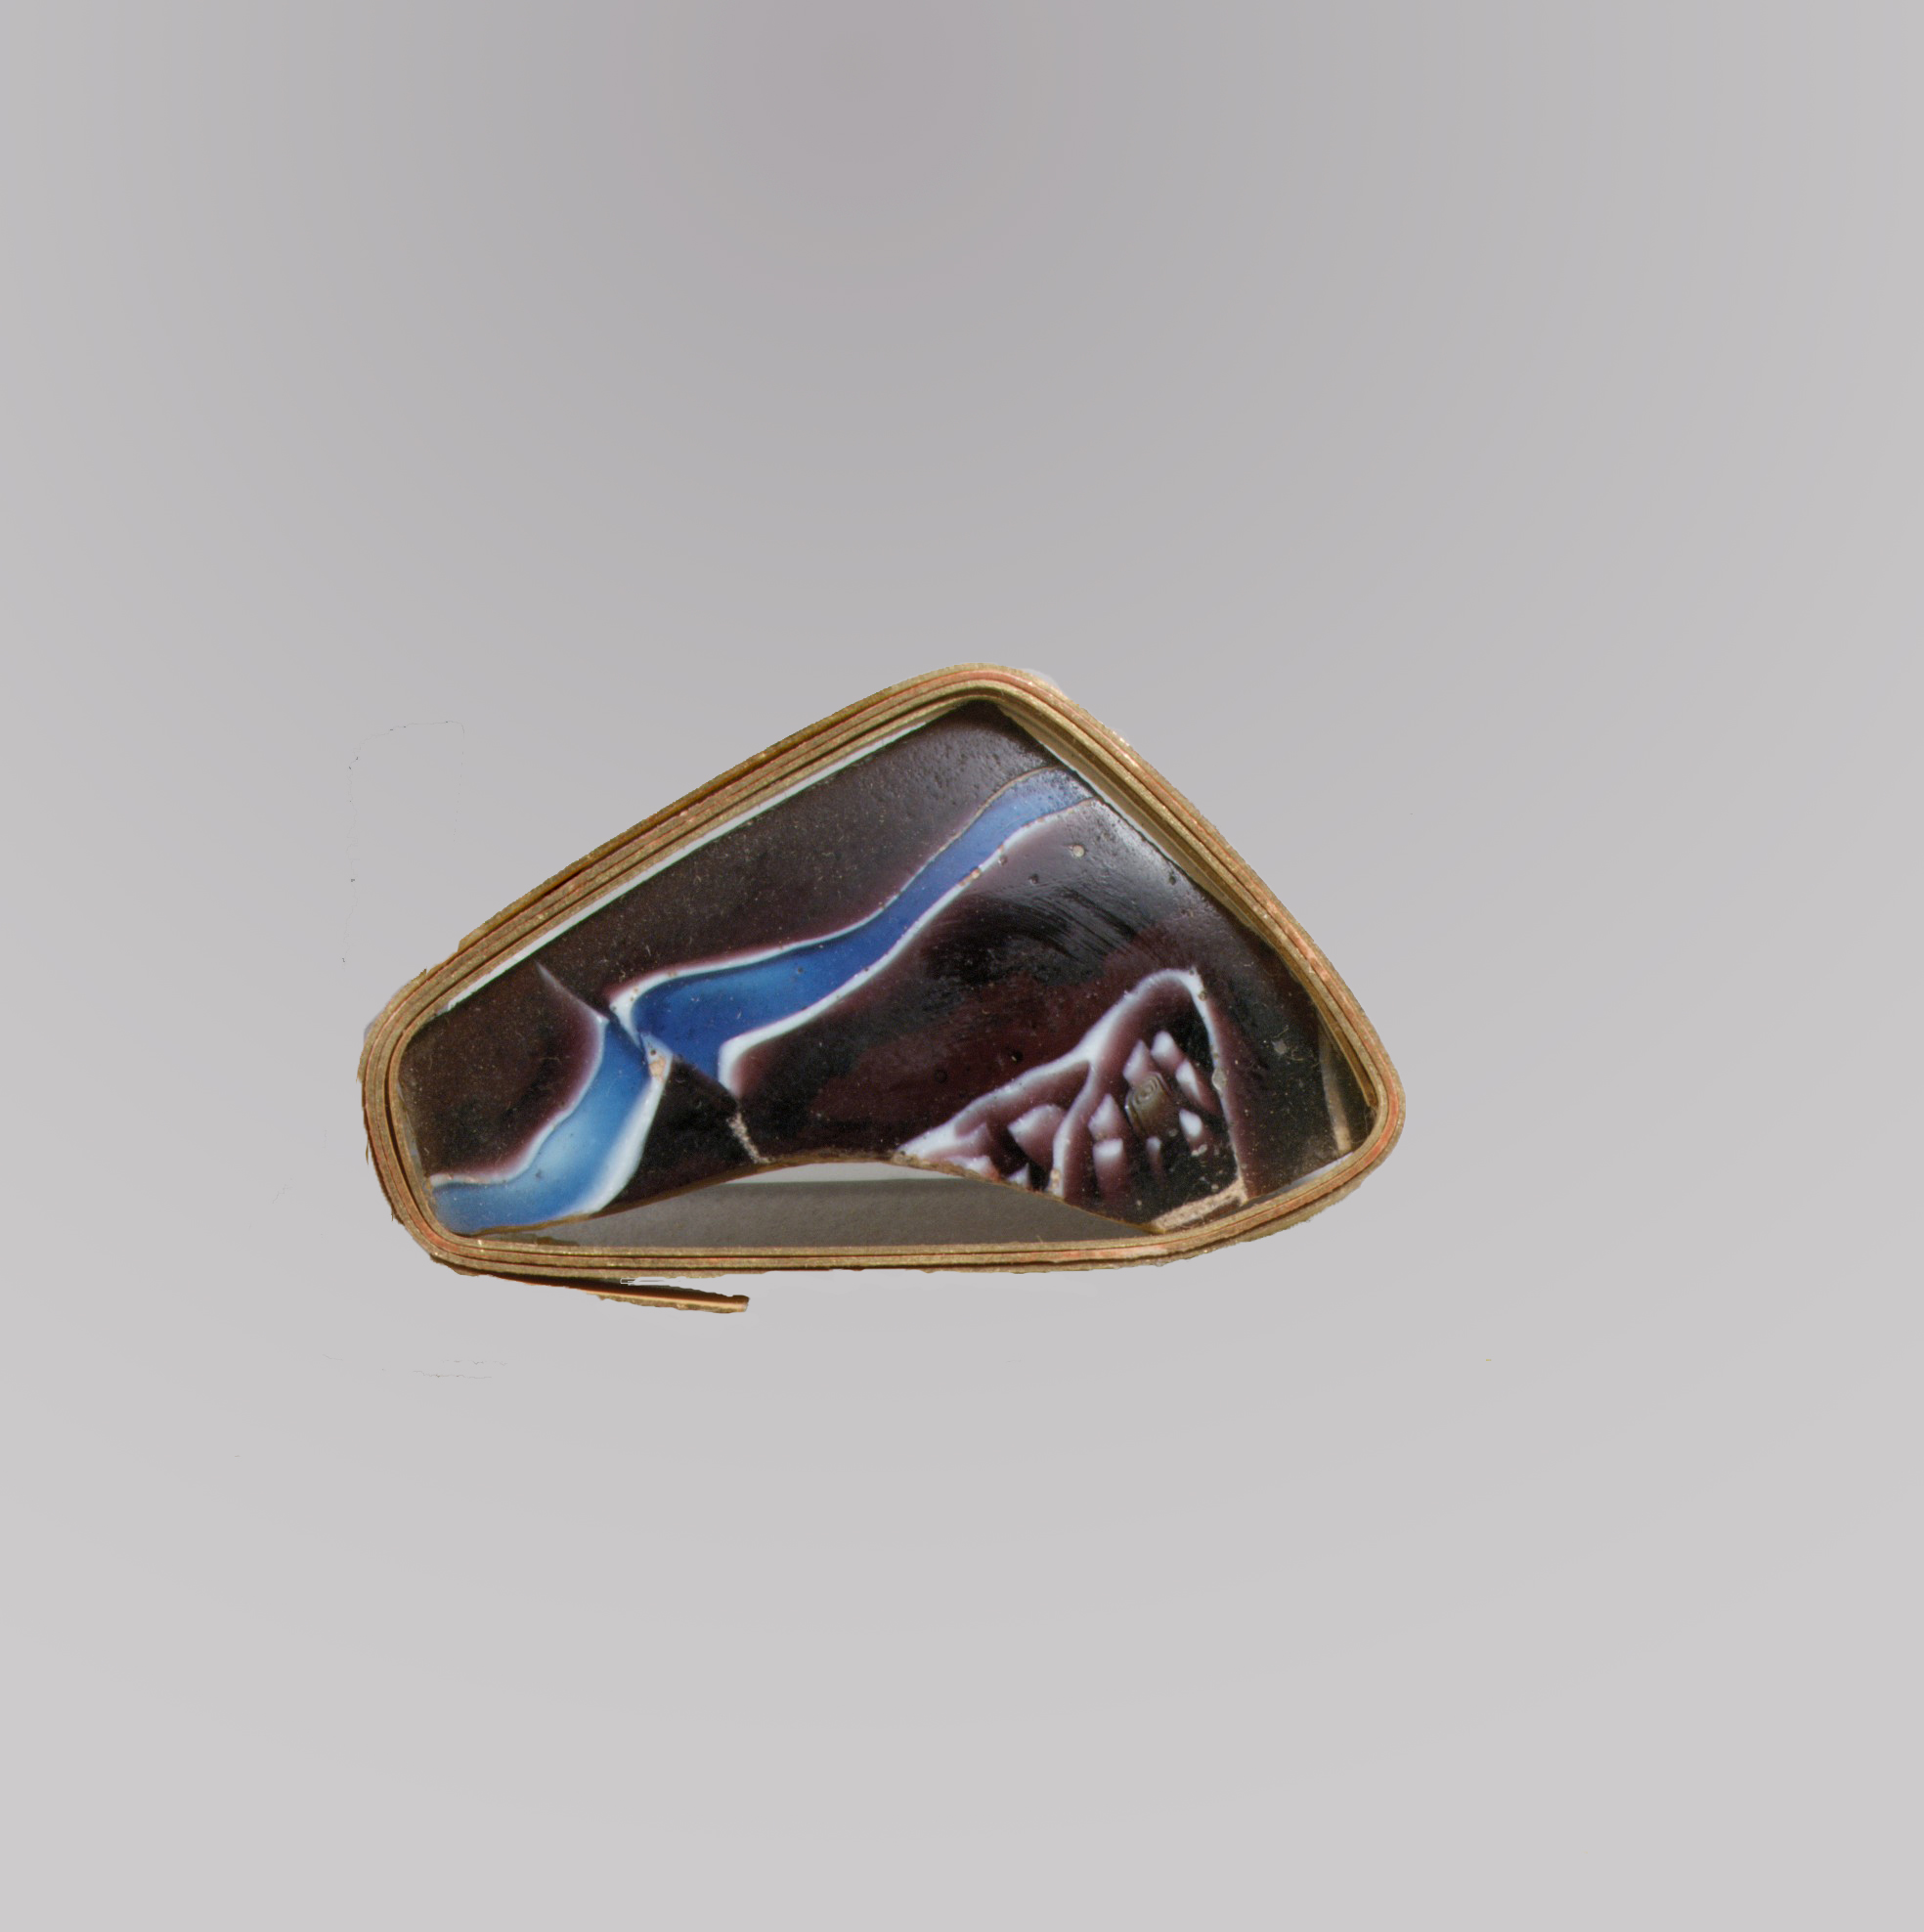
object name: fragment, mosaic bowl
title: Glass mosaic bowl fragment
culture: roman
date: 34 BCE-33 CE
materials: glass